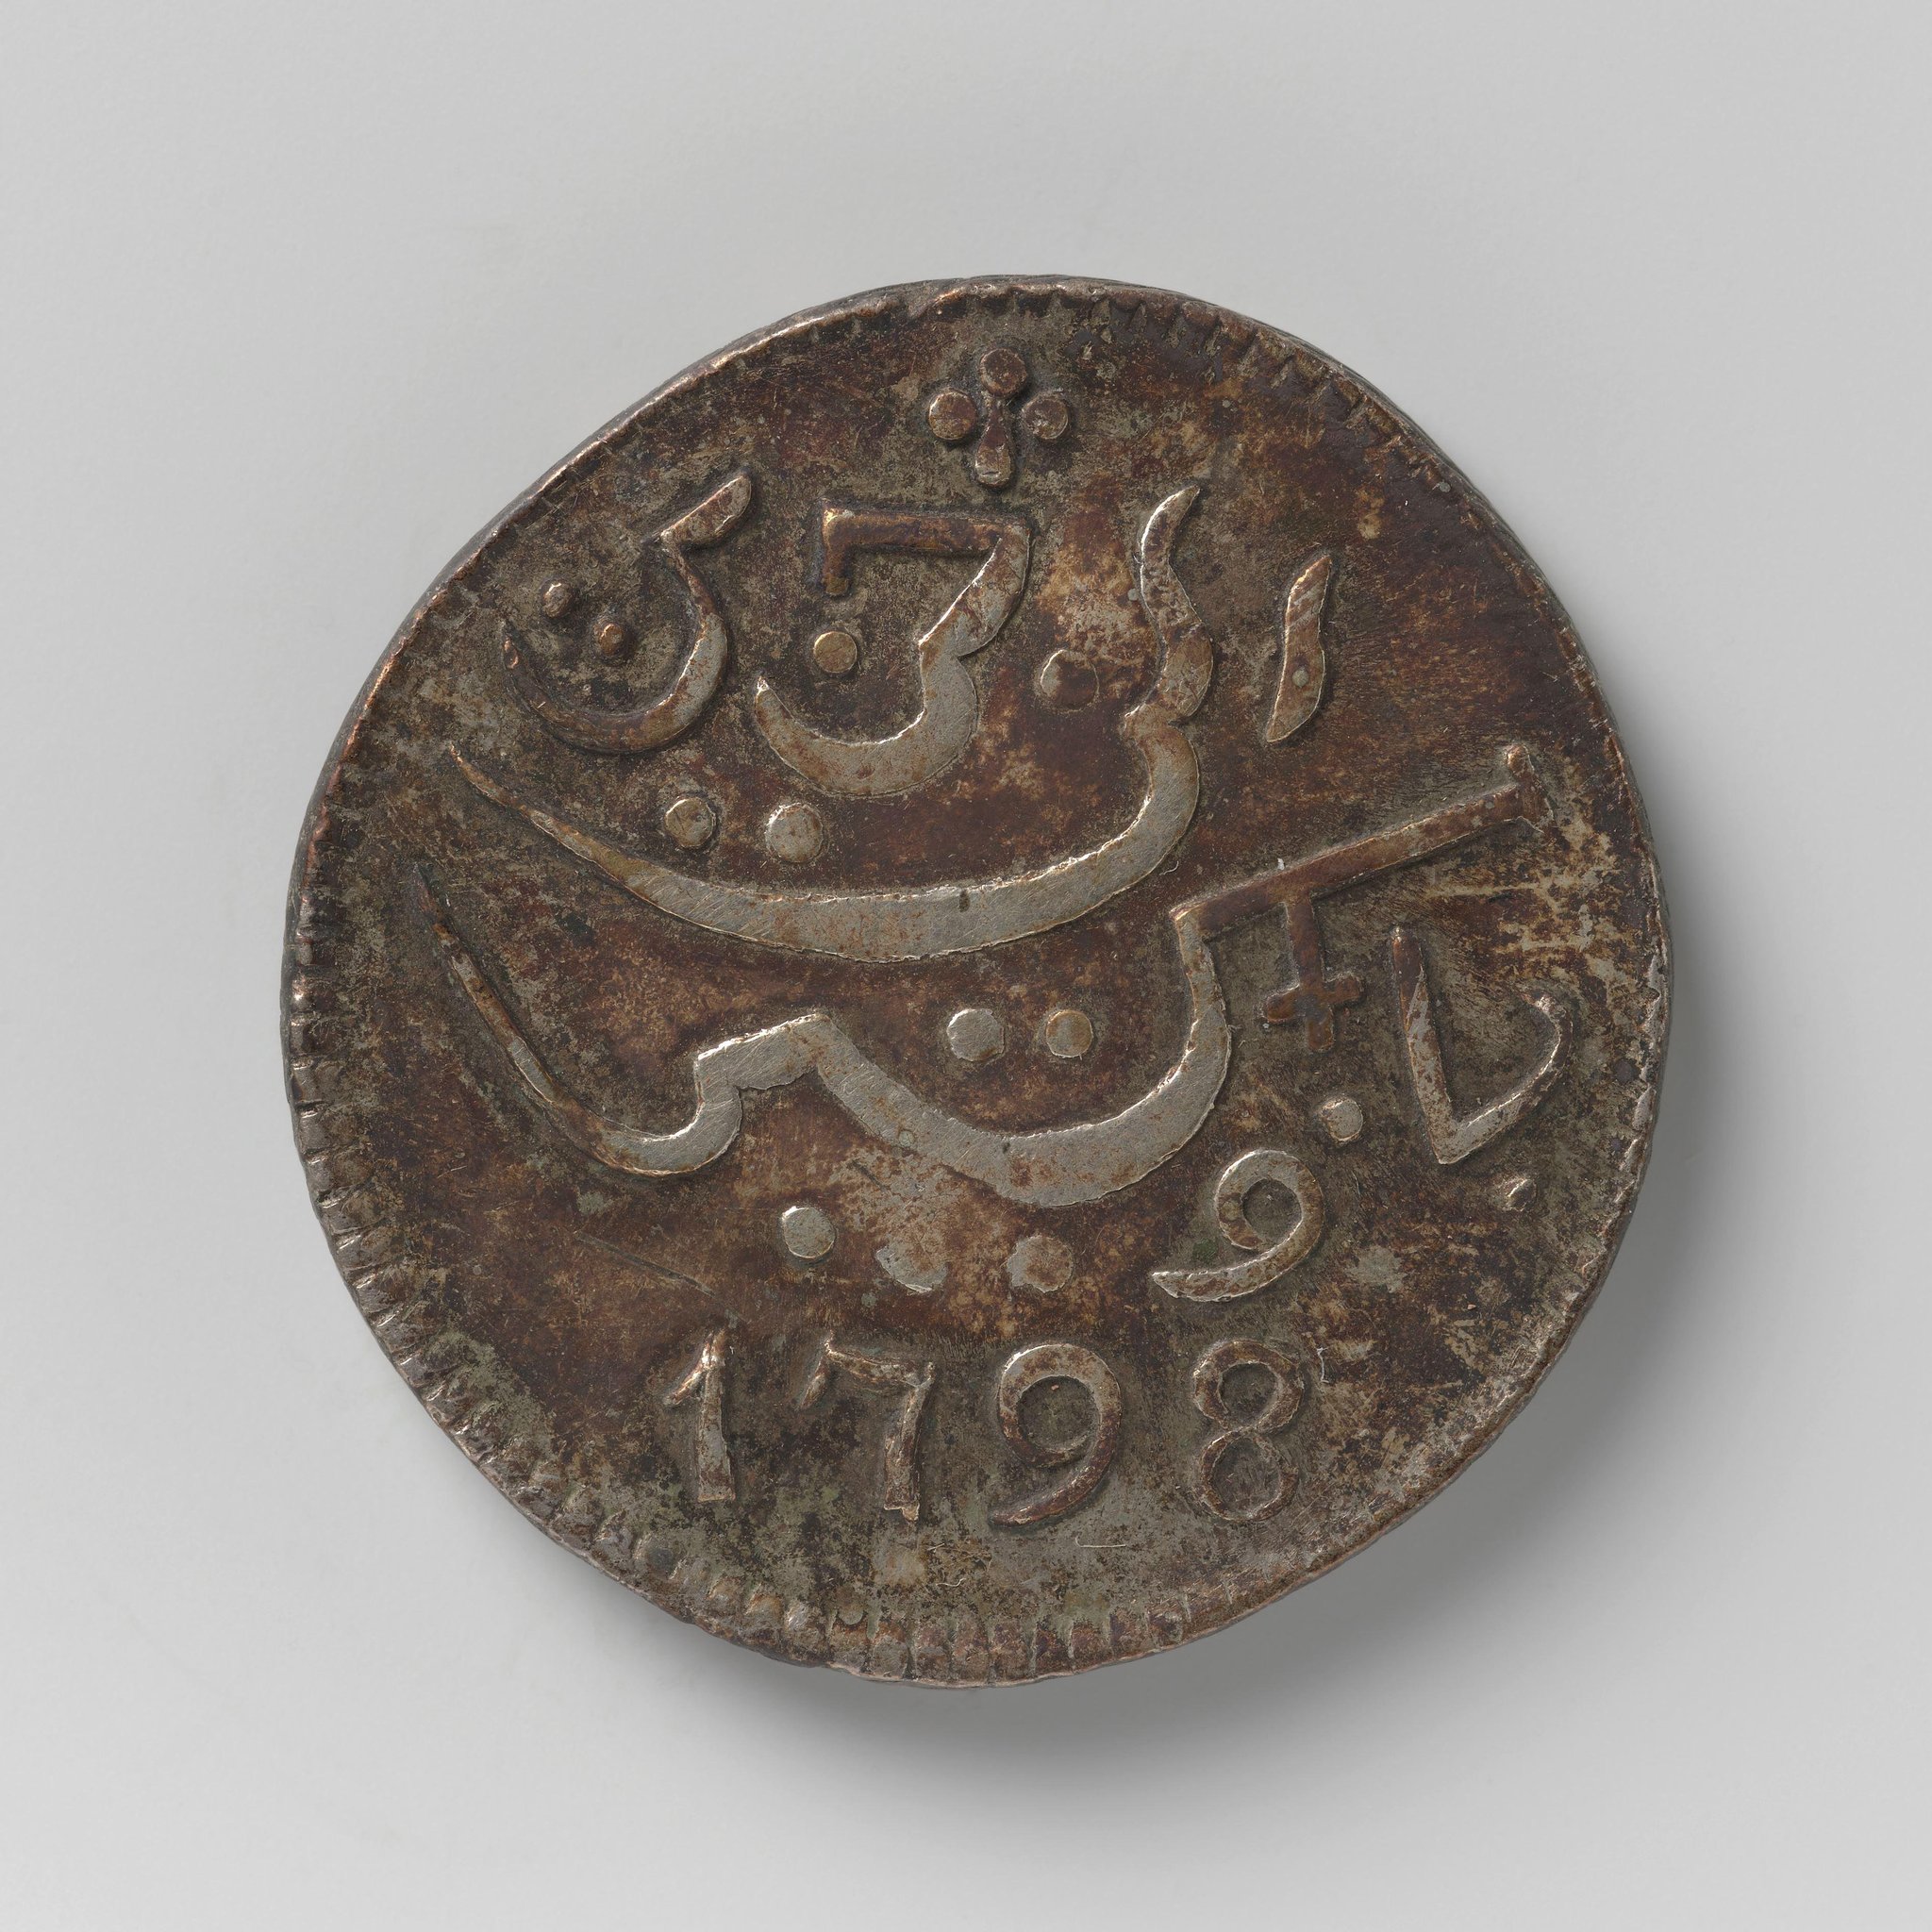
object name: coin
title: Zilveren ropij van de VOC uit Java, 1798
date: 1798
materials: silver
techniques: striking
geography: batavia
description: Zilveren munt. Voorzijde: tweeregelig opschrift in Arabische letters. Daarboven muntteken en daaronder jaartal. Keerzijde: drieregelig opschrift in Arabische letters. Kabelrand. Op keerzijde is een keurmerk ingeslagen.